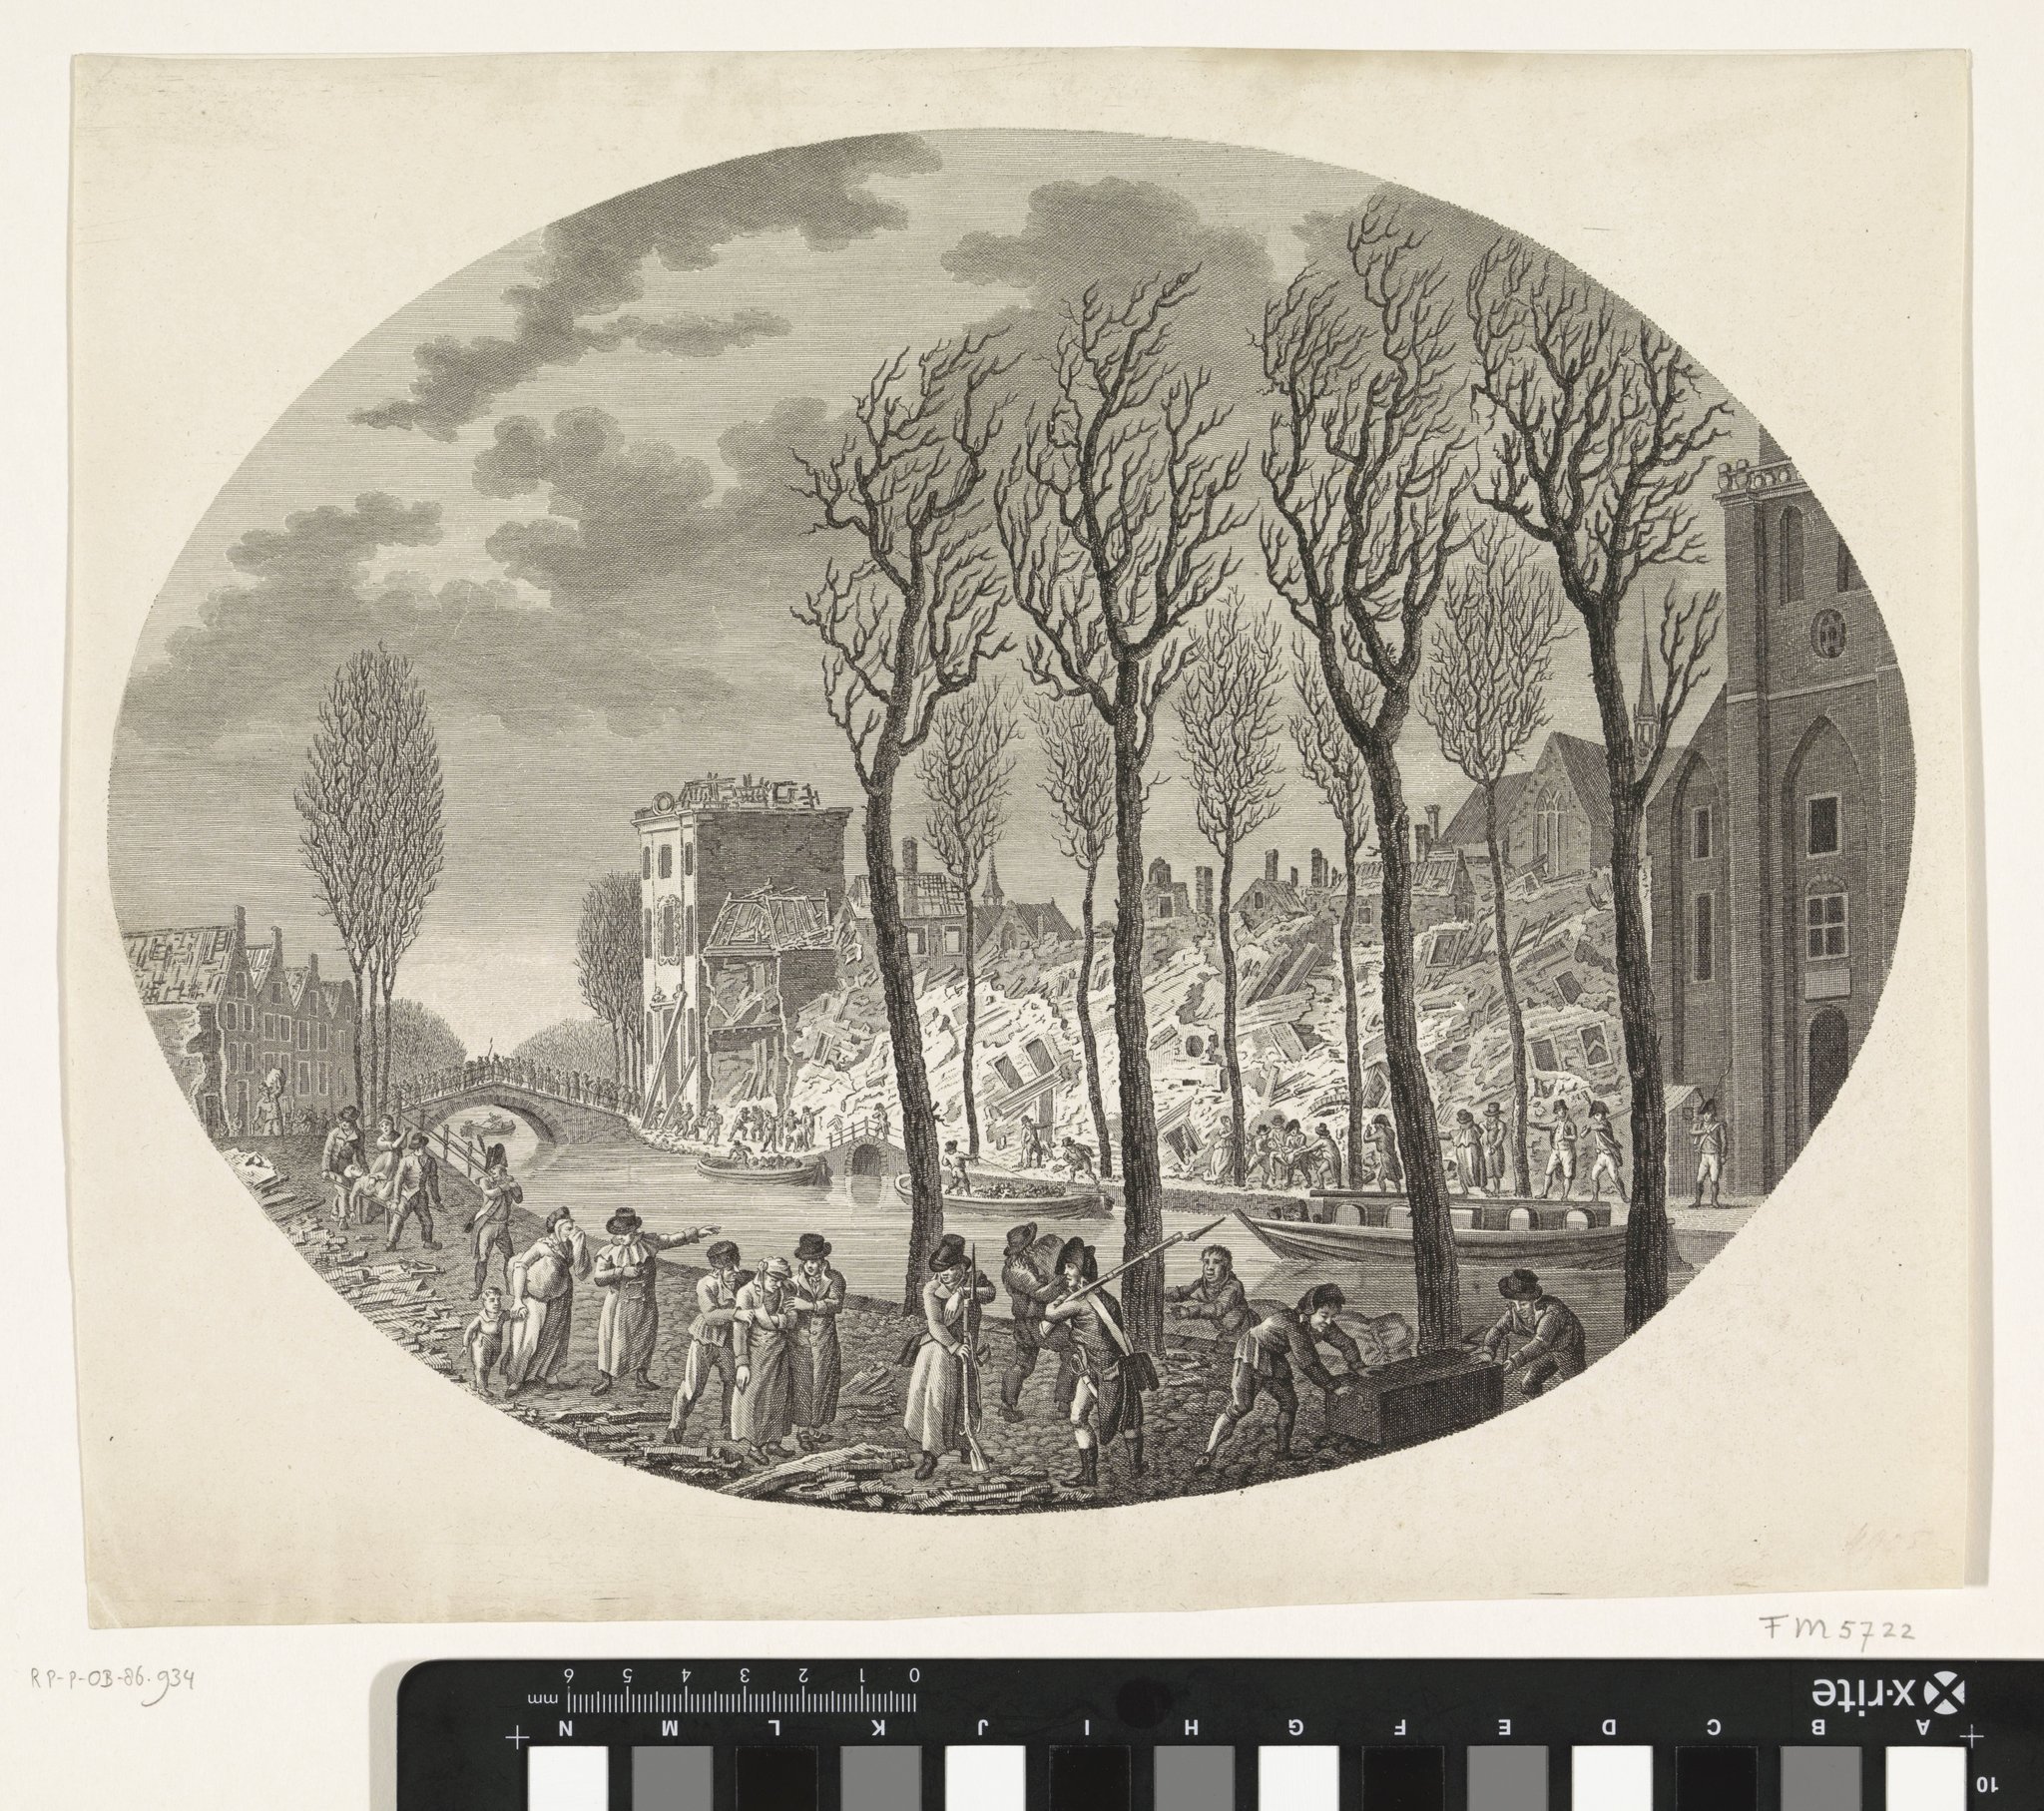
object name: print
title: Ruïnes te Leiden na de buskruitramp, 1807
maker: joannes bemme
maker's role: print maker, printer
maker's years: 1775-1841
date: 1807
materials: paper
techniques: engraving, etching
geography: netherlands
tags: gunpowder disaster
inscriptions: collector's mark: Lugt 2228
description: Ovale voorstelling van het verwoeste gebied aan de noordzijde op het Steenschuur met de Saaihal te Leiden na de buskruitramp op 12 januari 1807.